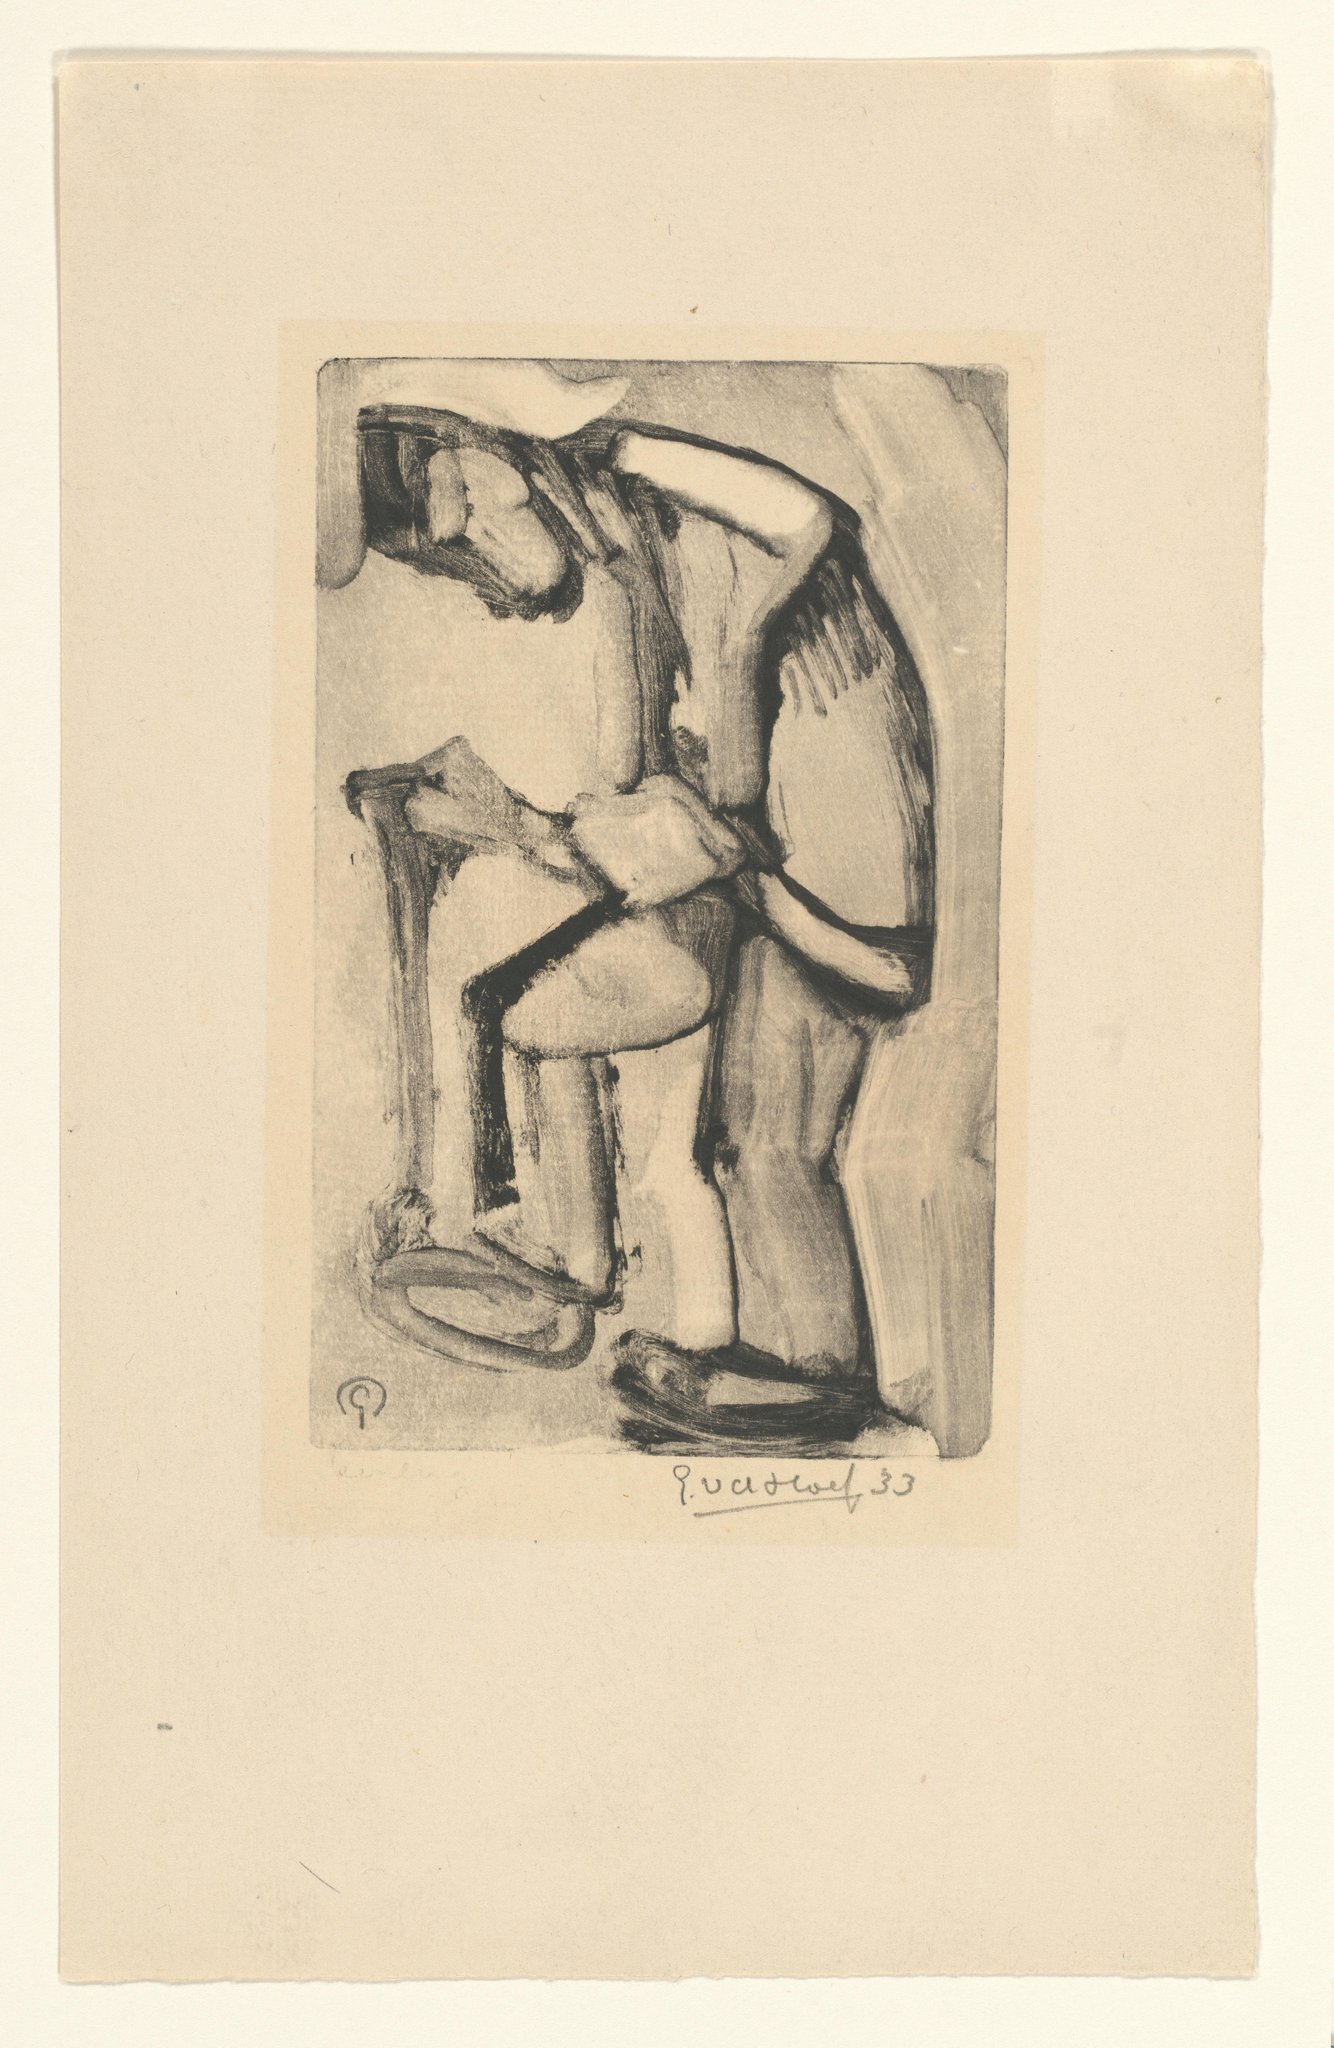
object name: print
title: Voorovergebogen boer met schop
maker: gerrit van der hoef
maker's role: print maker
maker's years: 1879-1954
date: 1933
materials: paper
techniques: monotype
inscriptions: signature and date: ‘G vd Hoef ‘33’